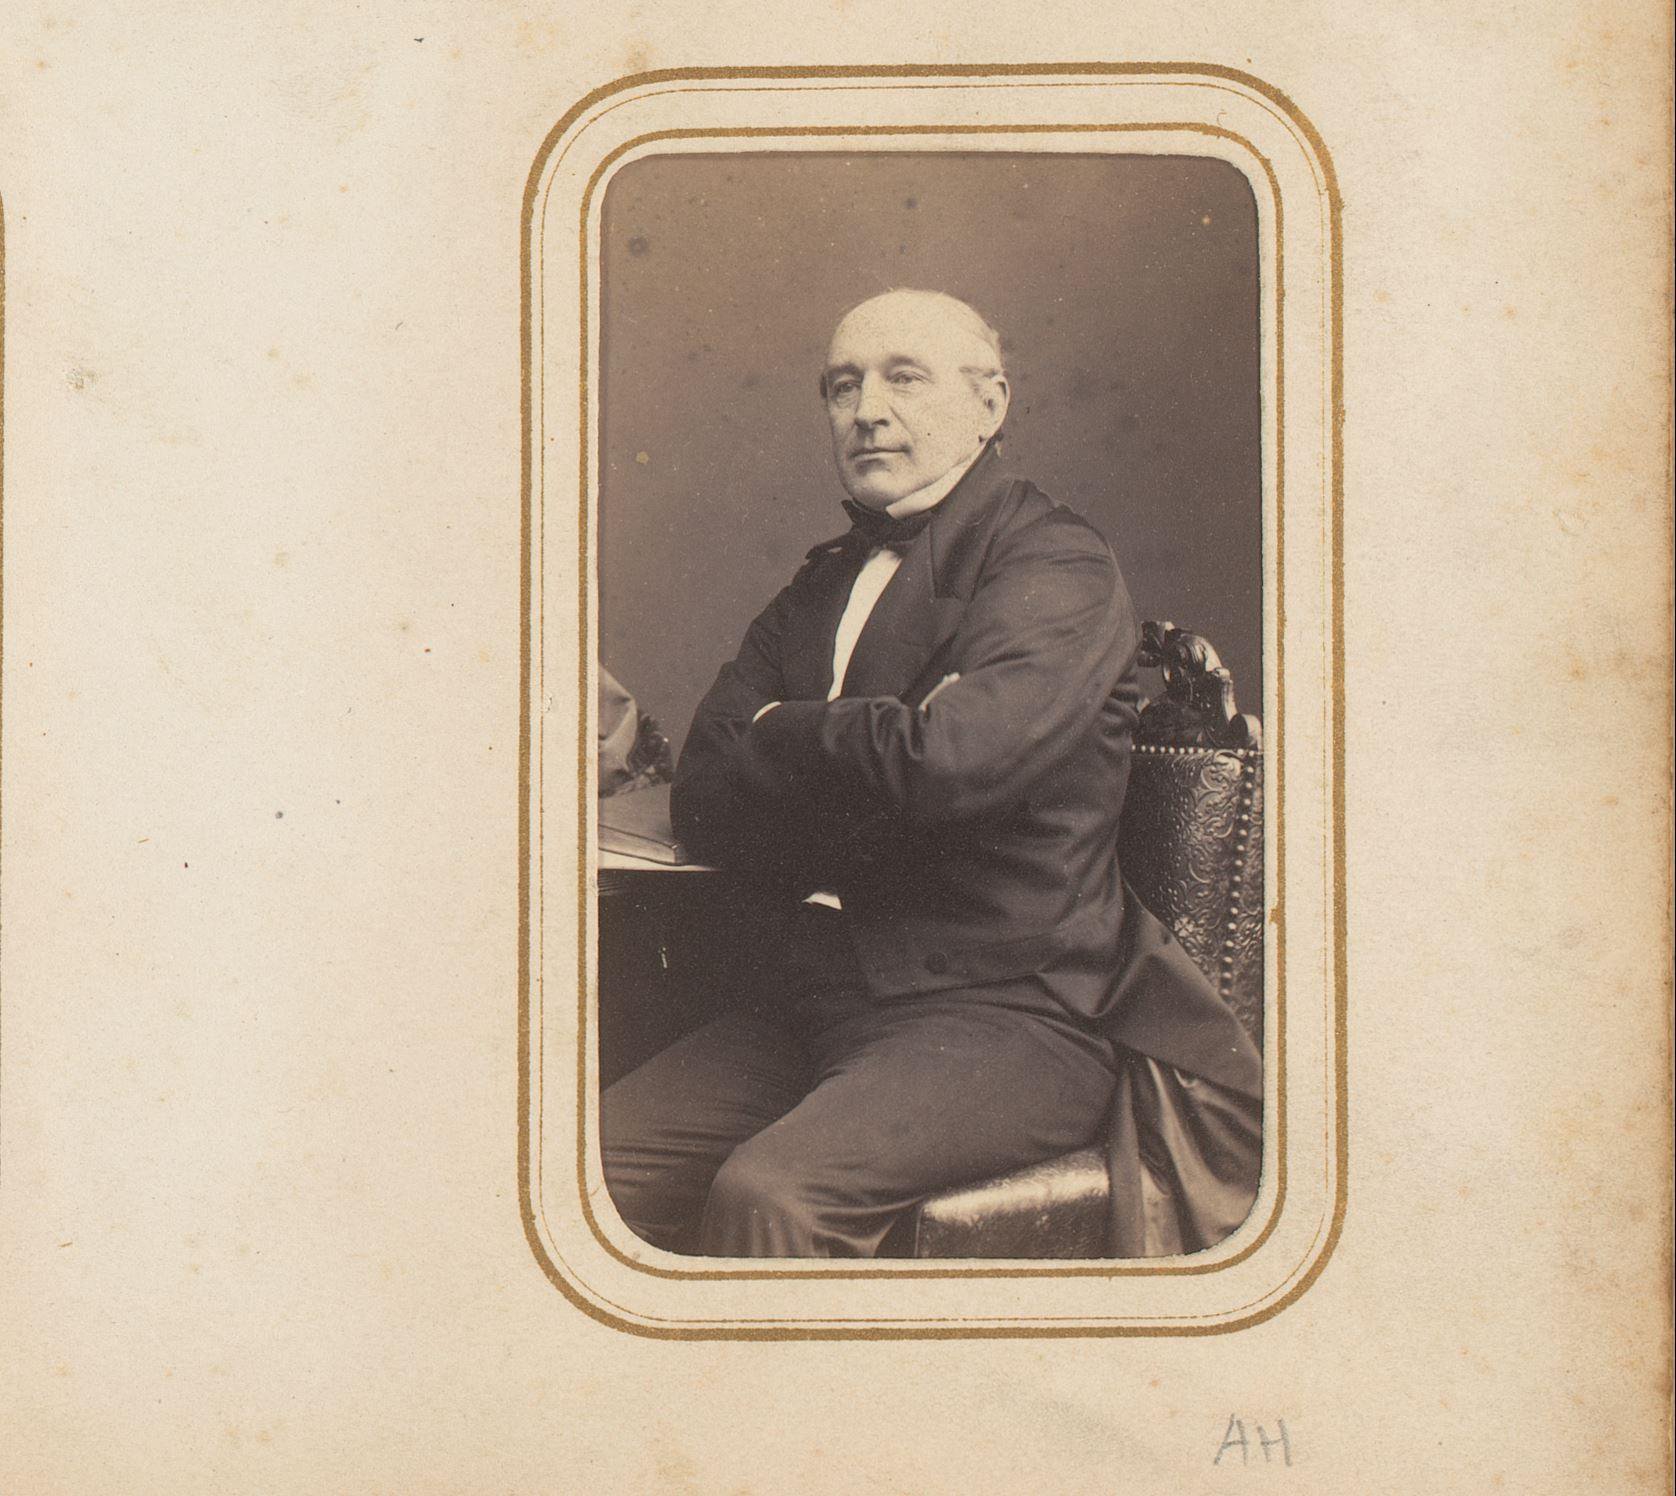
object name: photograph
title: Portret van een zittende man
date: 1857-1864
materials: cardboard, photographic support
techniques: albumen print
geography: amsterdam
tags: historical persons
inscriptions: inscription: ‘Photogr. Atelier/ Wegner & Mottu/ Prinsengracht BB 439/ Amsterdam’